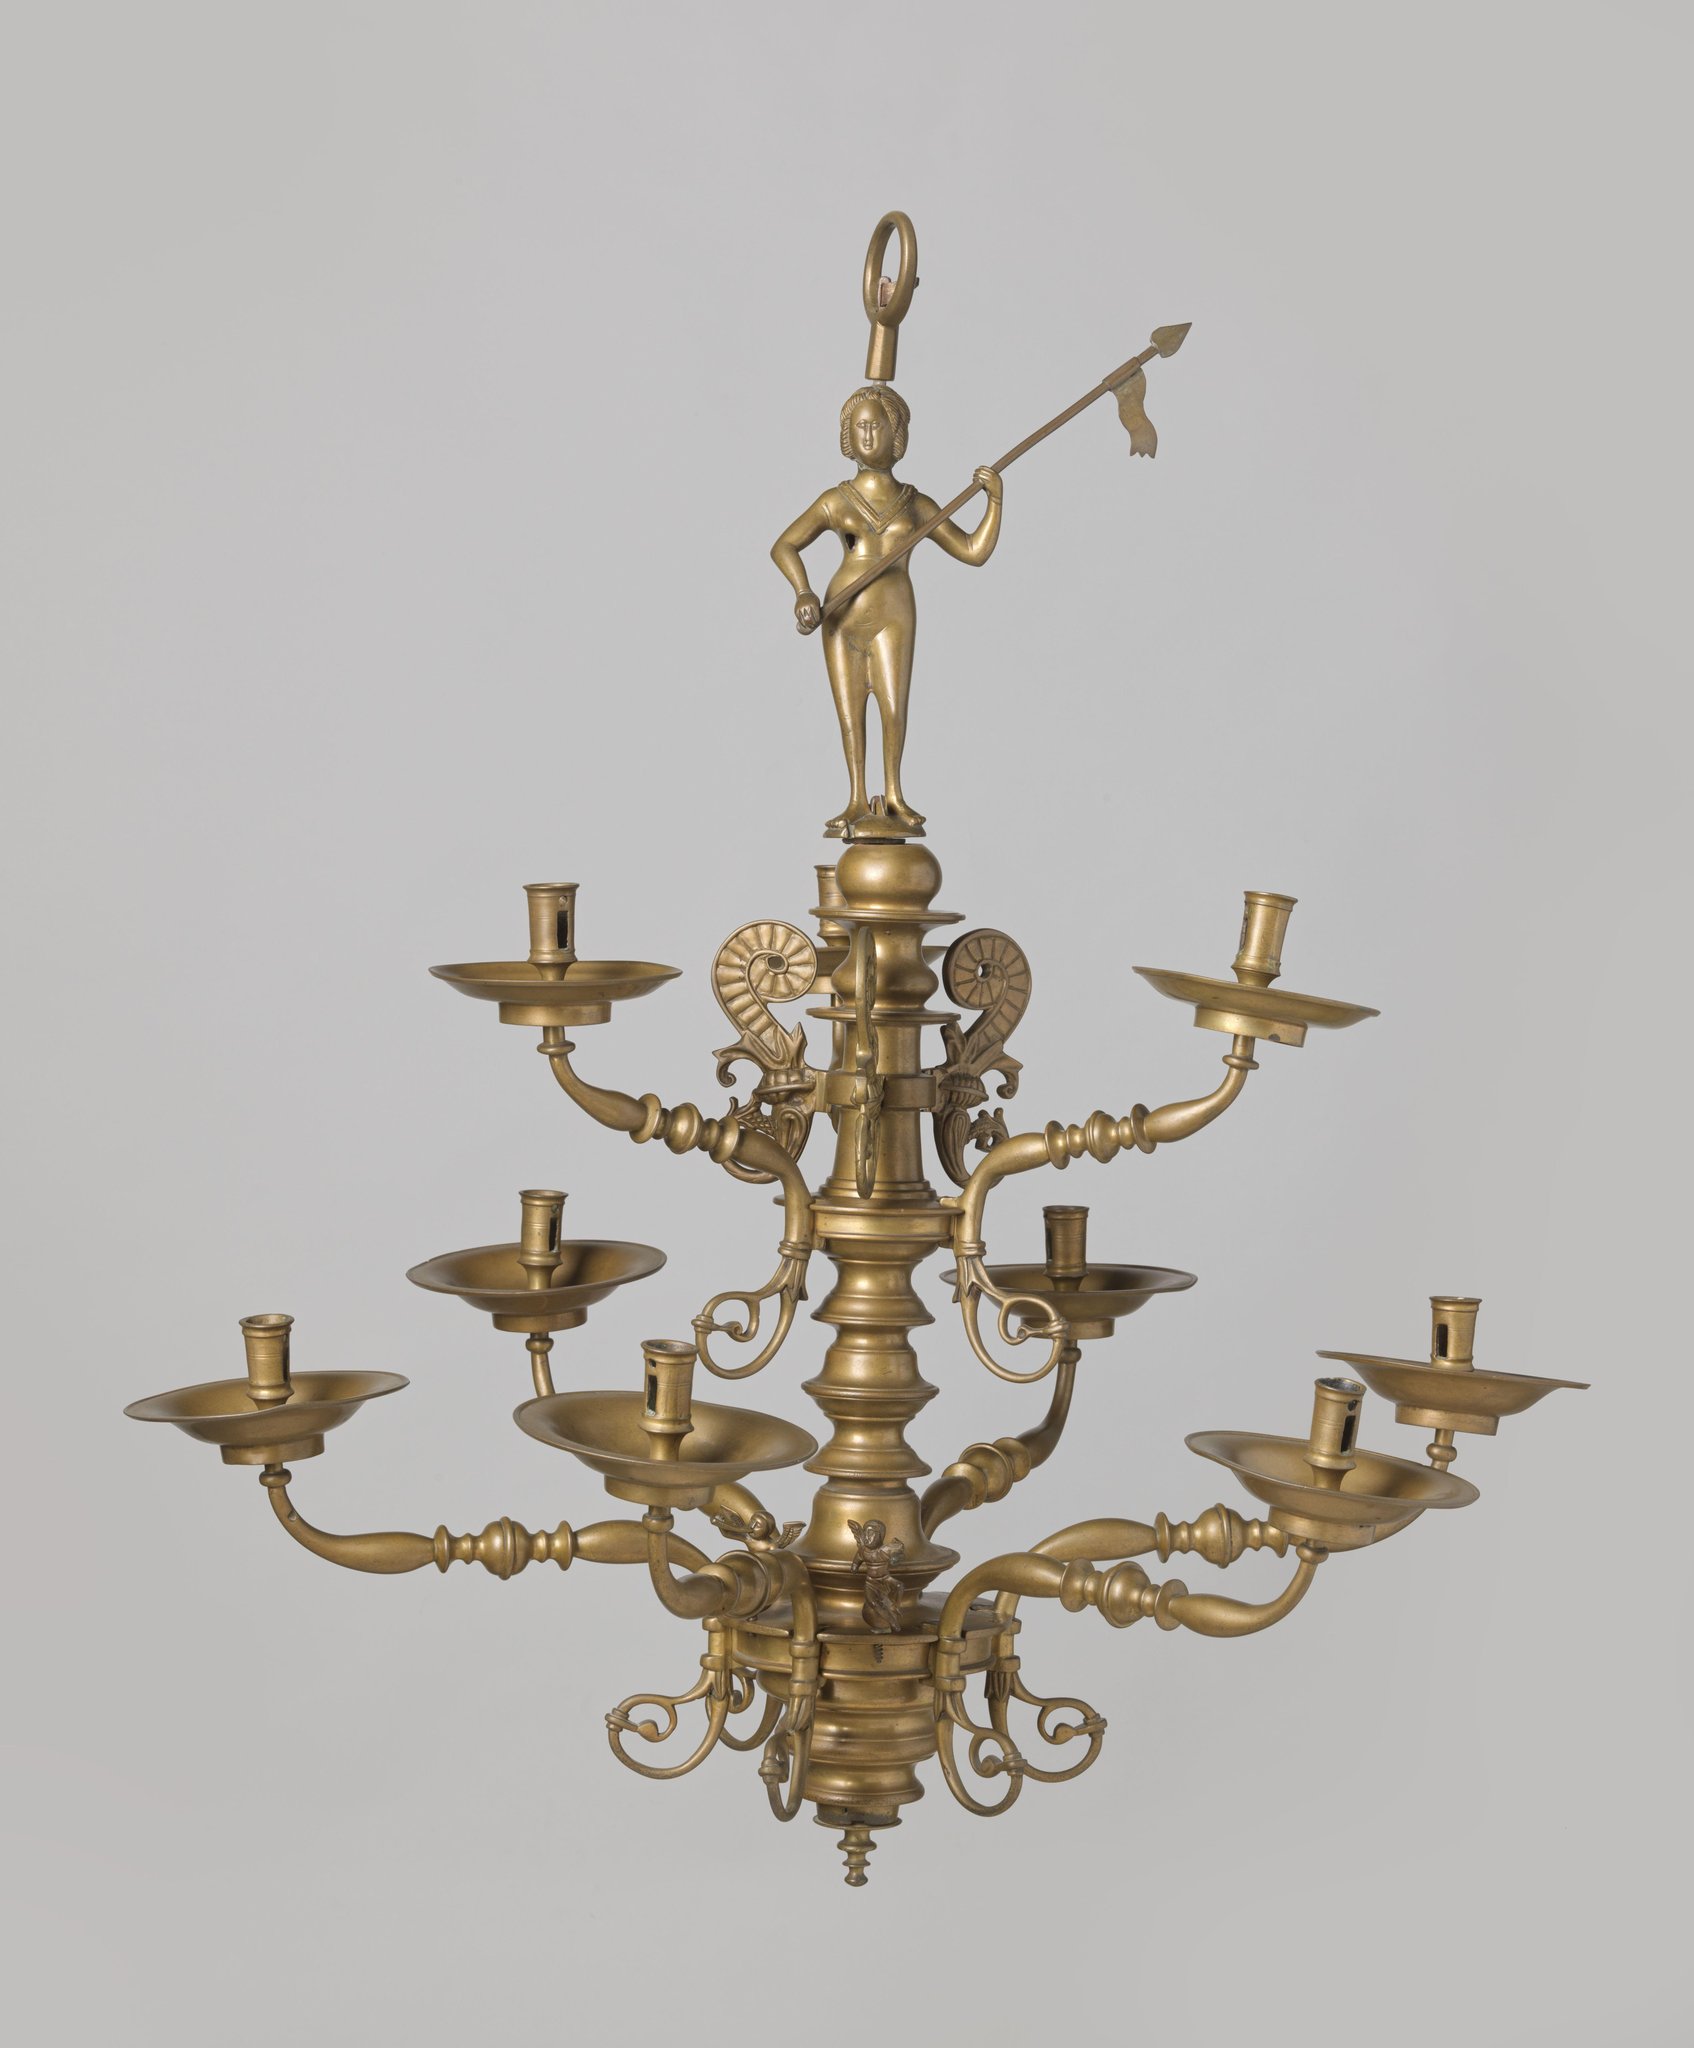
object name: chandelier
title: Arm met kaarsenhouder van kaarsenkroon van twee hoogten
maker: Anonymous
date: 1525-1575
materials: brass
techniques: casting, screwed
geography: lübeck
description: Kaarsenarm behorende bij een kaarsenkroon van twee hoogten met naakte vrouw bovenaan. De arm heeft in het midden een bol- en holrond geprofileerde nodus en verdikt zich een weinig aan weerszijden. Bij de stam loopt zij uit in een spiraalvormige krul. Naar buiten toe mondt zij uit in het schroefeind van ijzer. Daarop bevindt zich de ronde vetvanger met onderaan een afstaande rand. De ronde in elkaars verlengde opengewerkte kaarsenhouder heeft een holronde voet, die op de arm is geschroefd. Dit is de eerste arm van de bovenste ring, genummerd met 1 driehoekige punt (de tweede punt is niet zichtbaar). De kaarsenhouder is ongenummerd.